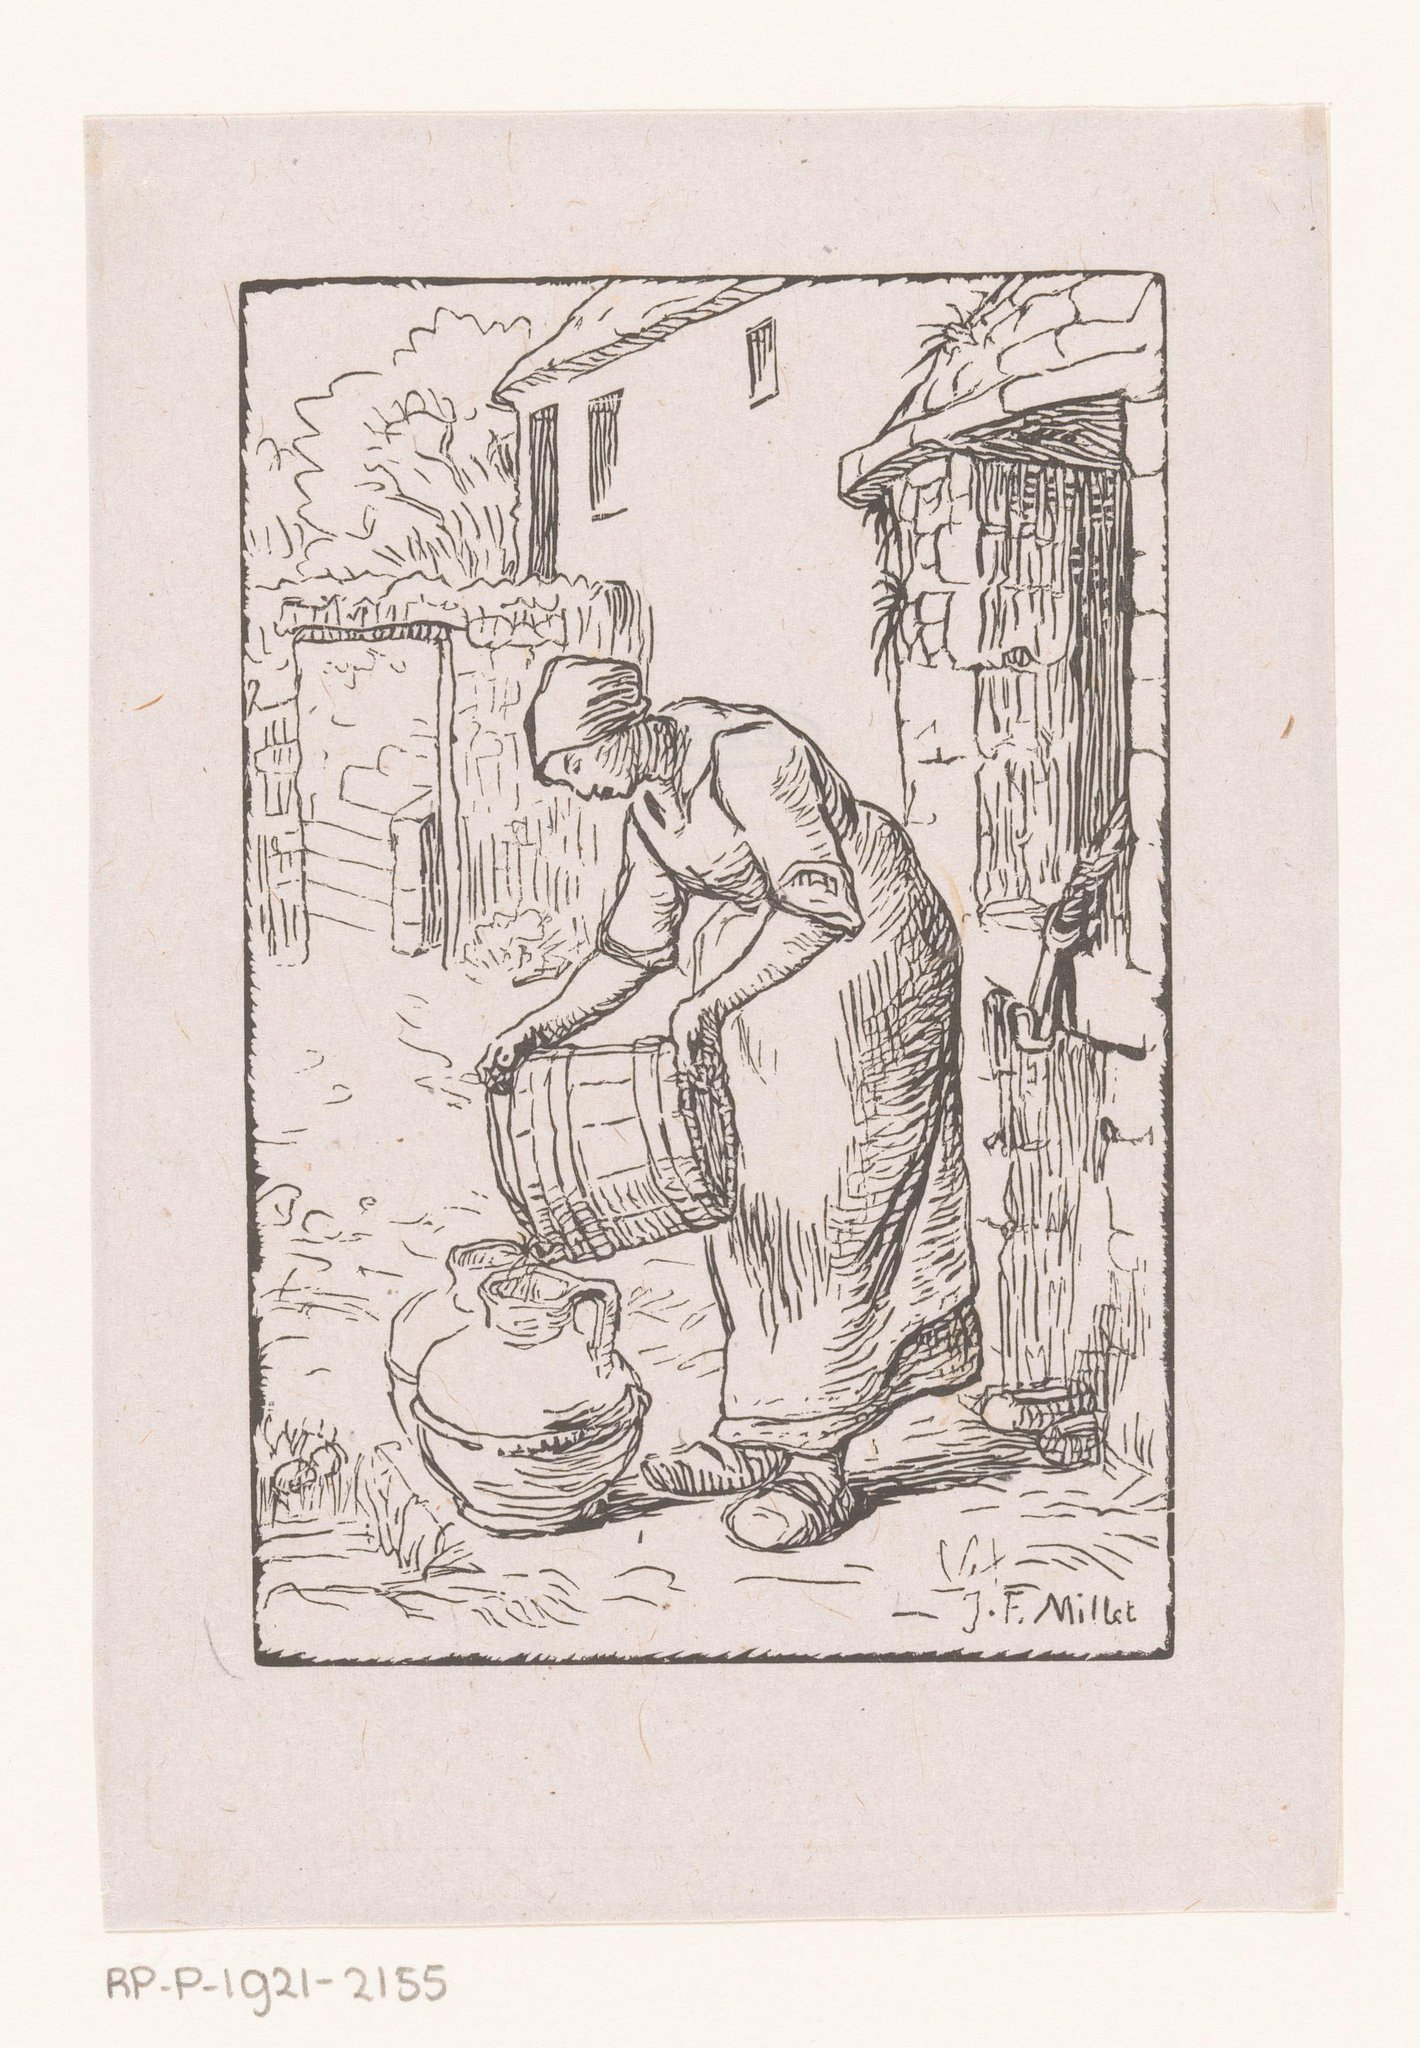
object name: print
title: Vrouw die een emmer leegt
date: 1834-1875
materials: paper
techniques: woodcut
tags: wooden container: barrel, cask, bucket